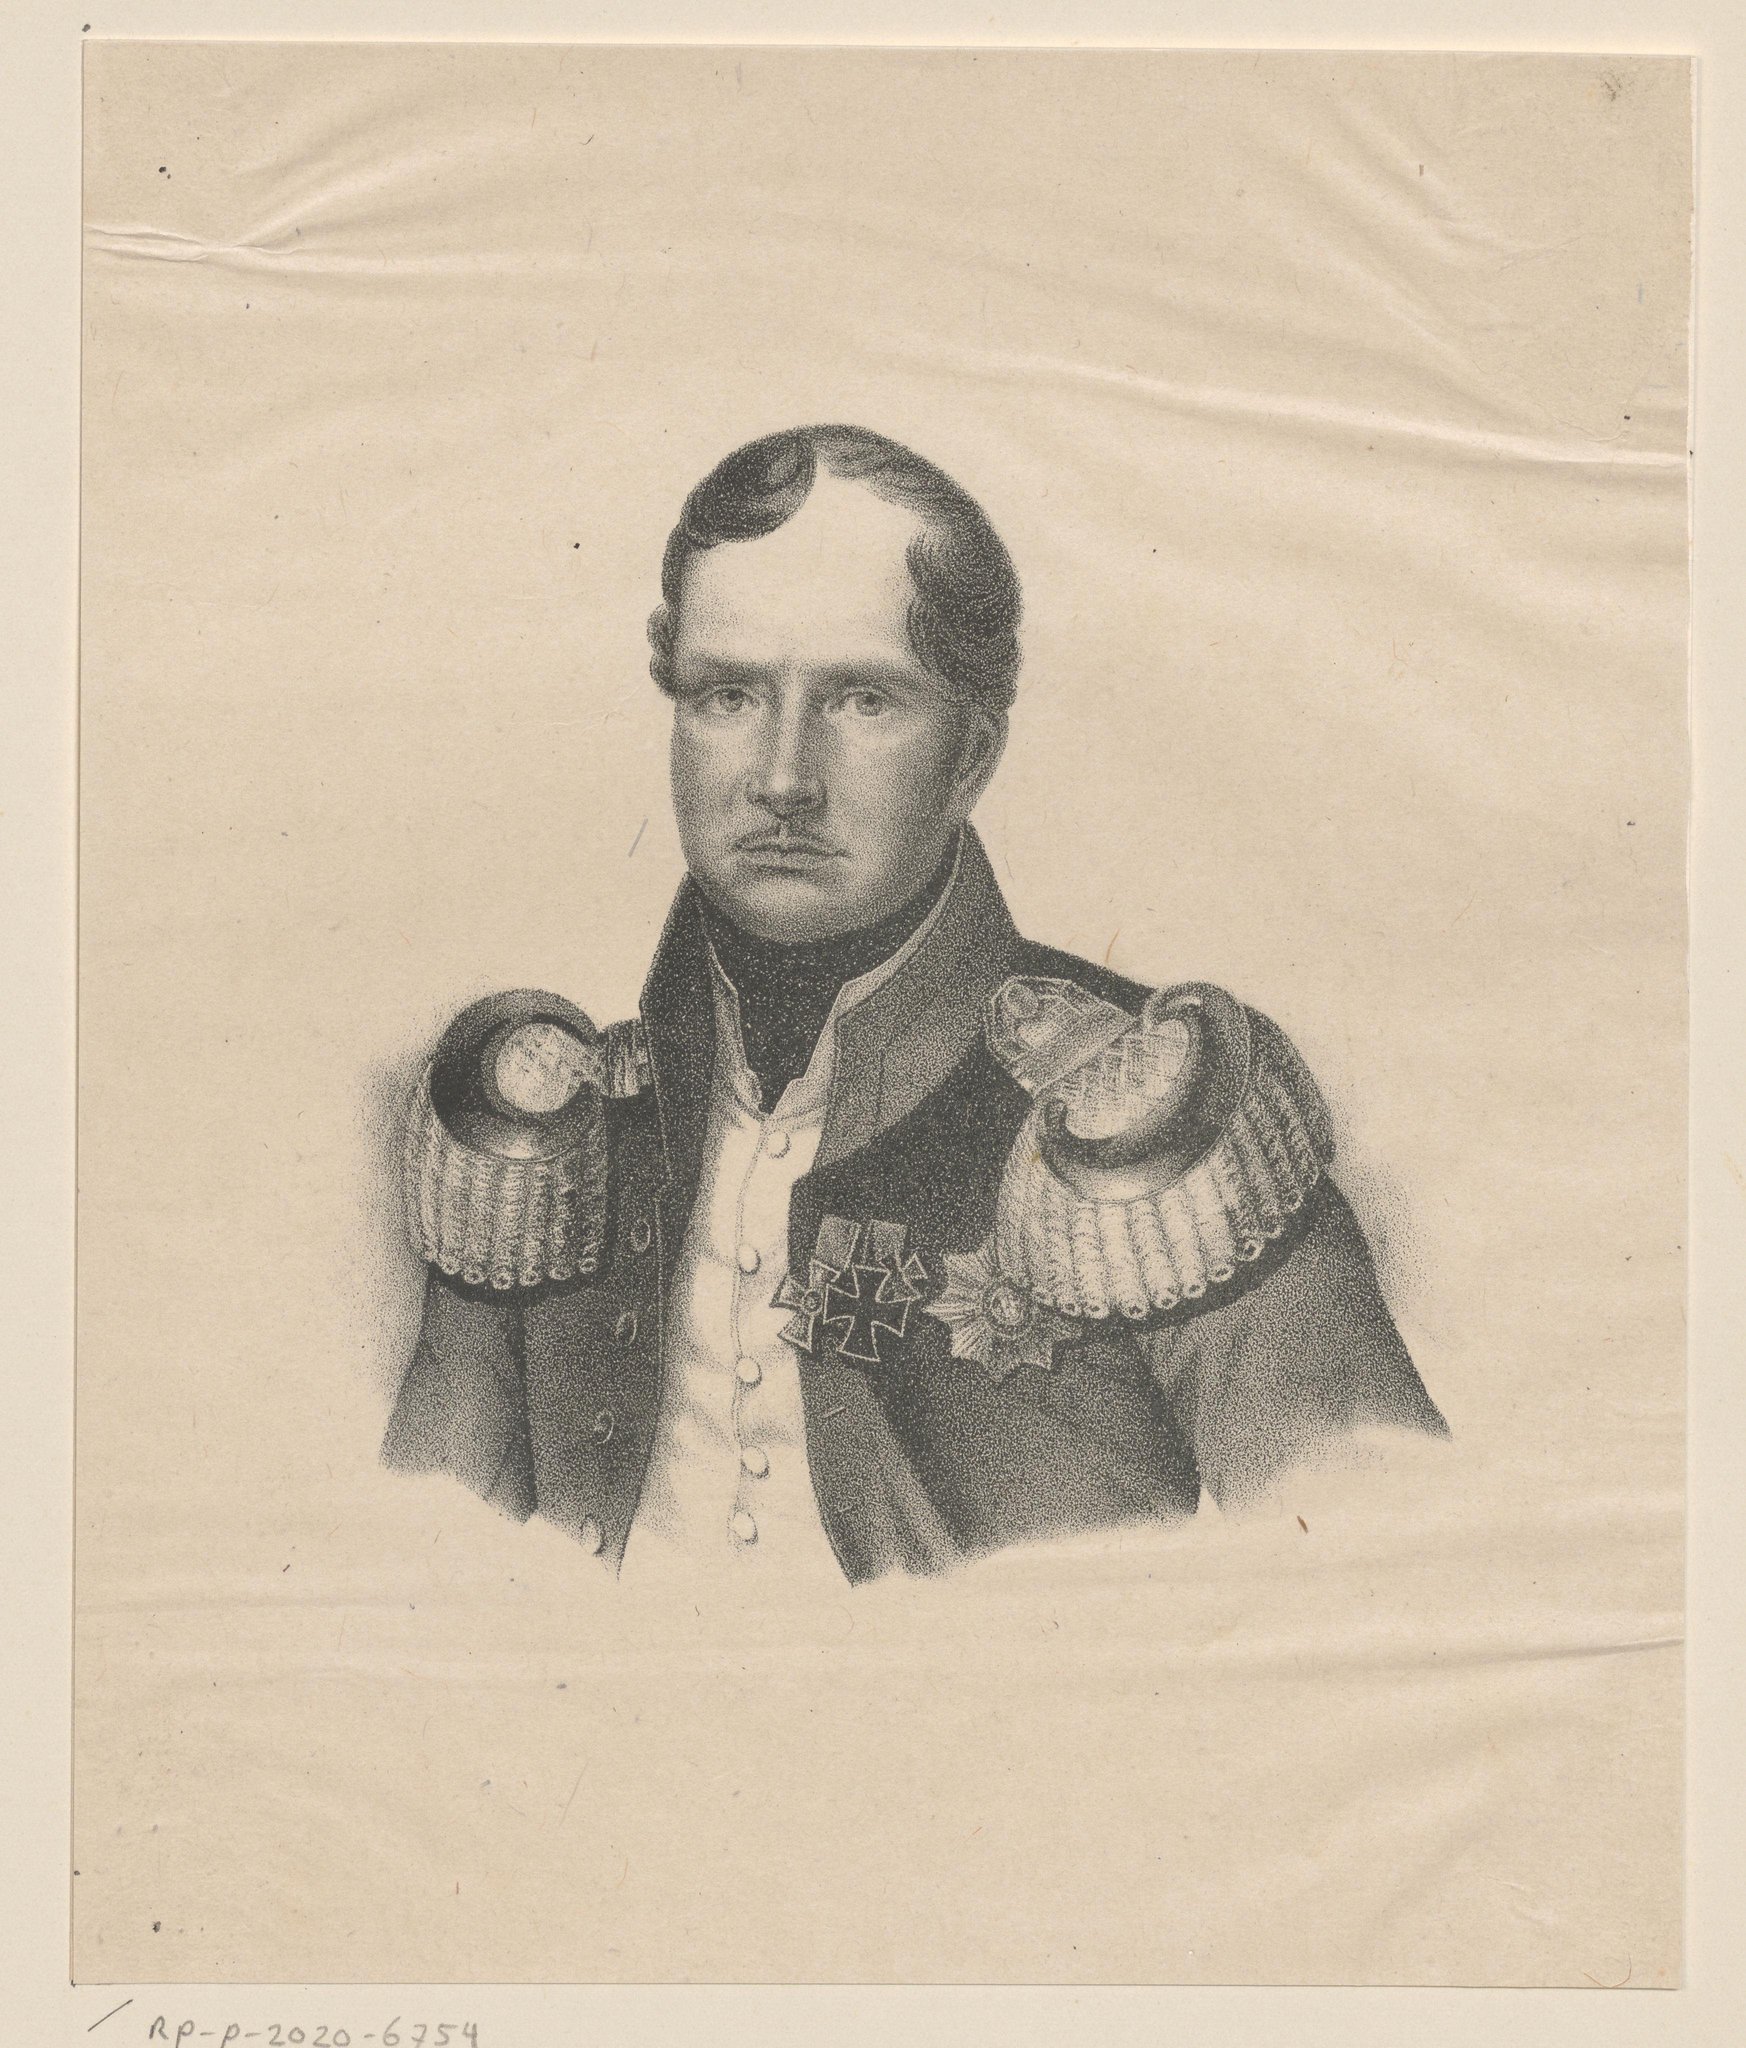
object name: print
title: Portret van Frederik Willem III van Pruisen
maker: Anonymous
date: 1800-1850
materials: paper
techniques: lithograph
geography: germany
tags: frederik willem iii koning van pruisen, historical persons, (military) uniforms, king